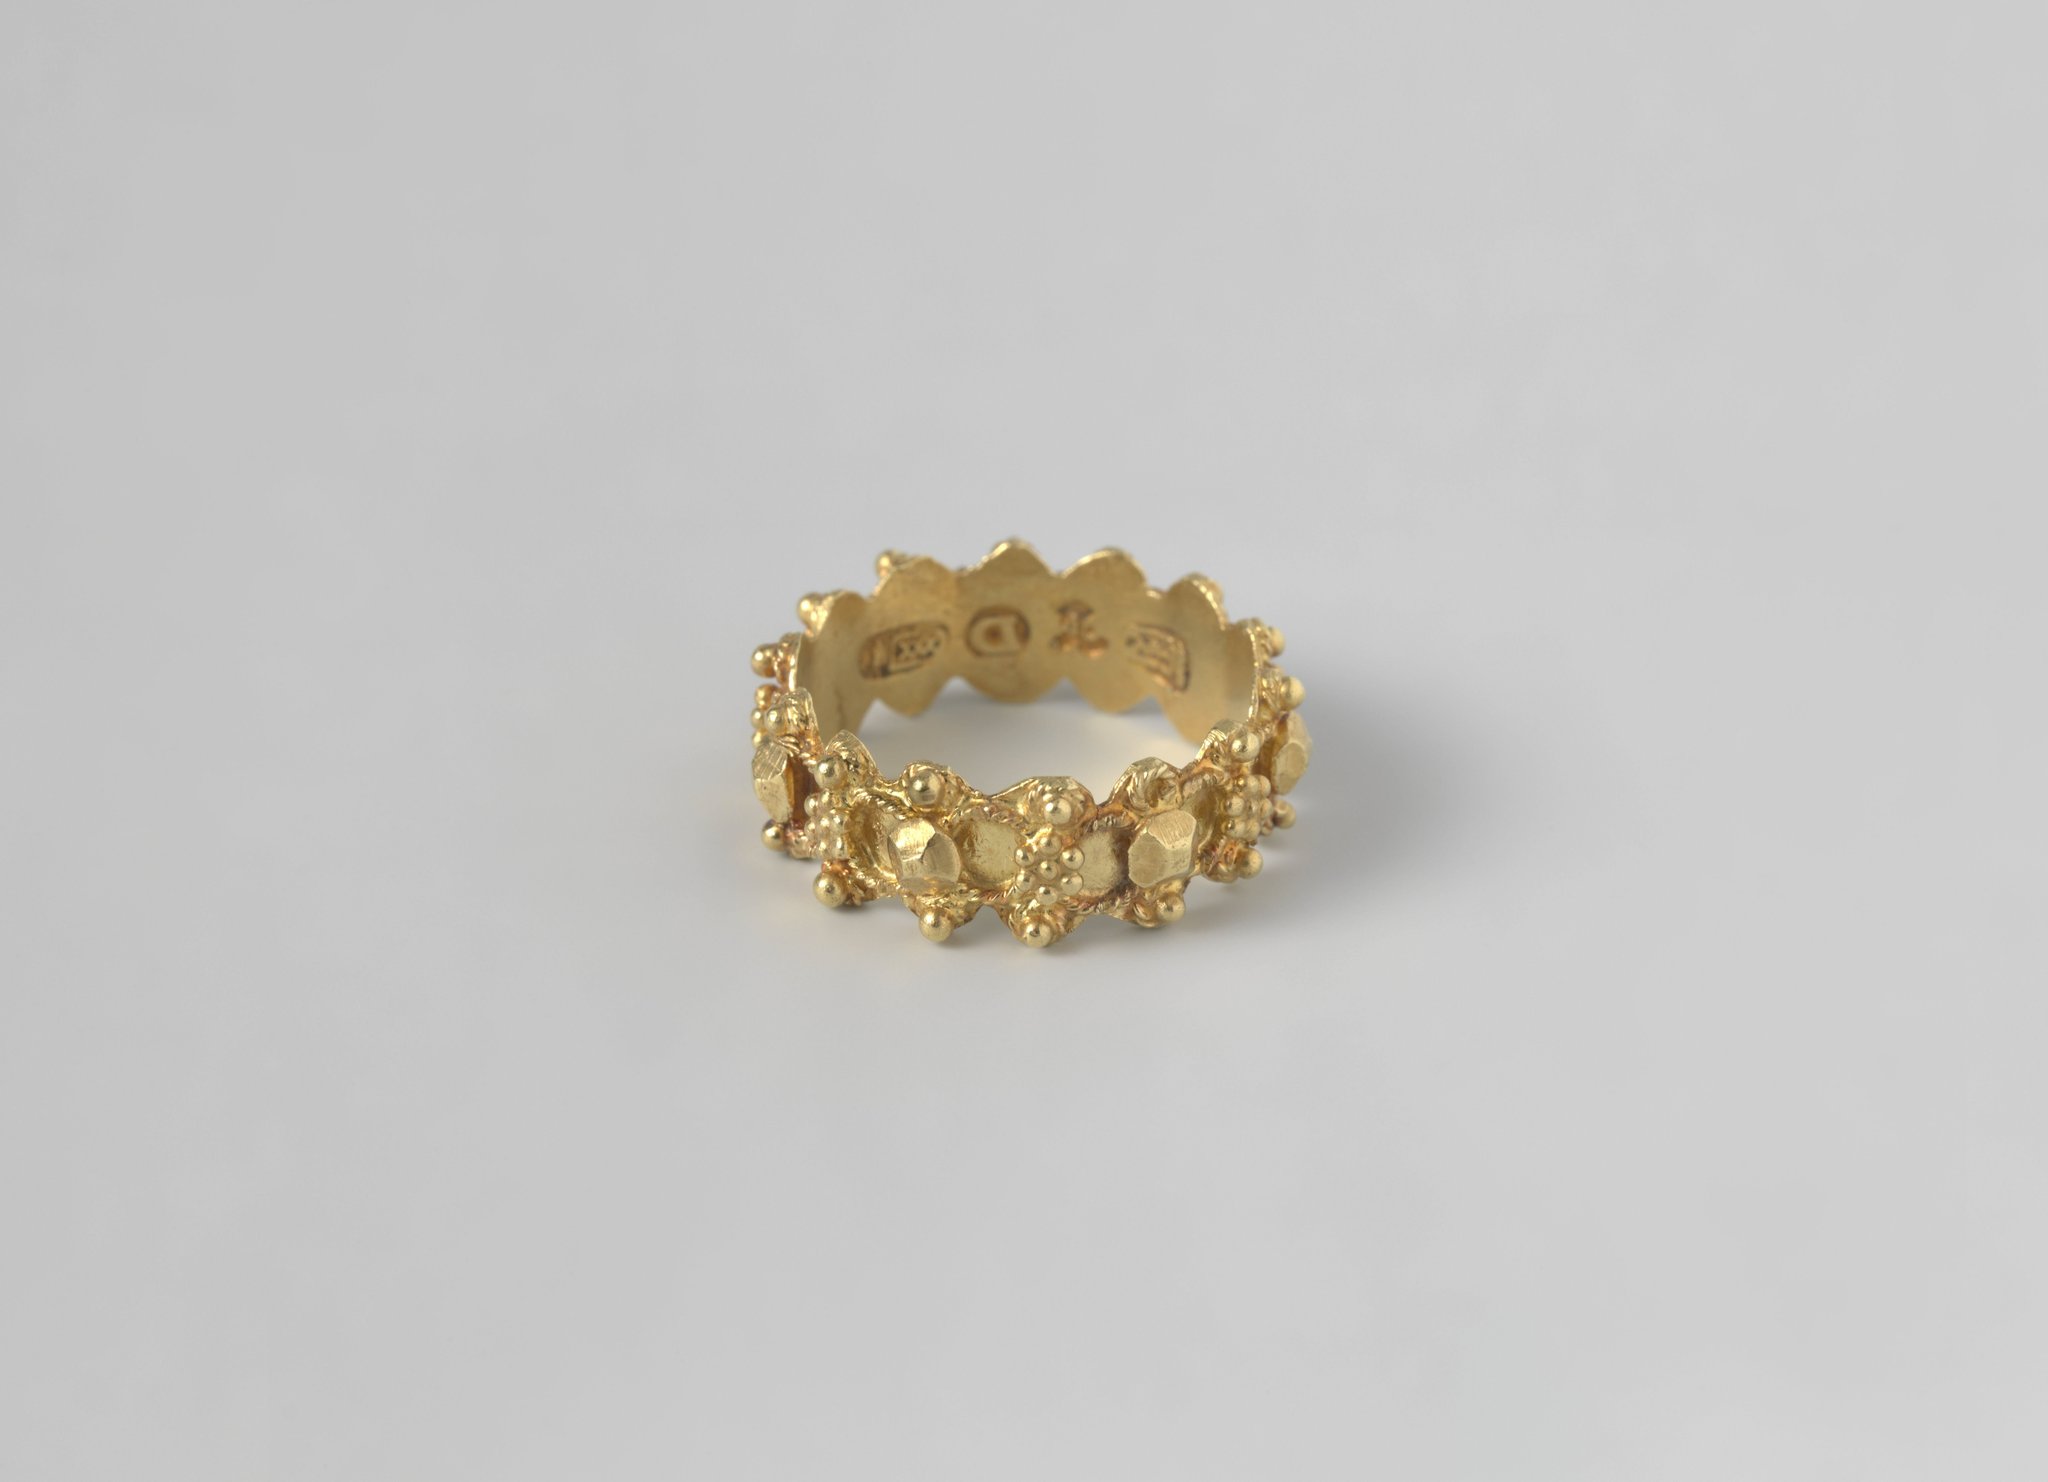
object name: ring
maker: Anonymous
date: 1738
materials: gold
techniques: filigree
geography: amsterdam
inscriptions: maker's mark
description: Gouden ring versierd met tussen twee uitgeschulpte parelrandjes een krans van oogjes van filigrein op de raakpunten vastgehouden door afwisselend knopjes en rozetten.